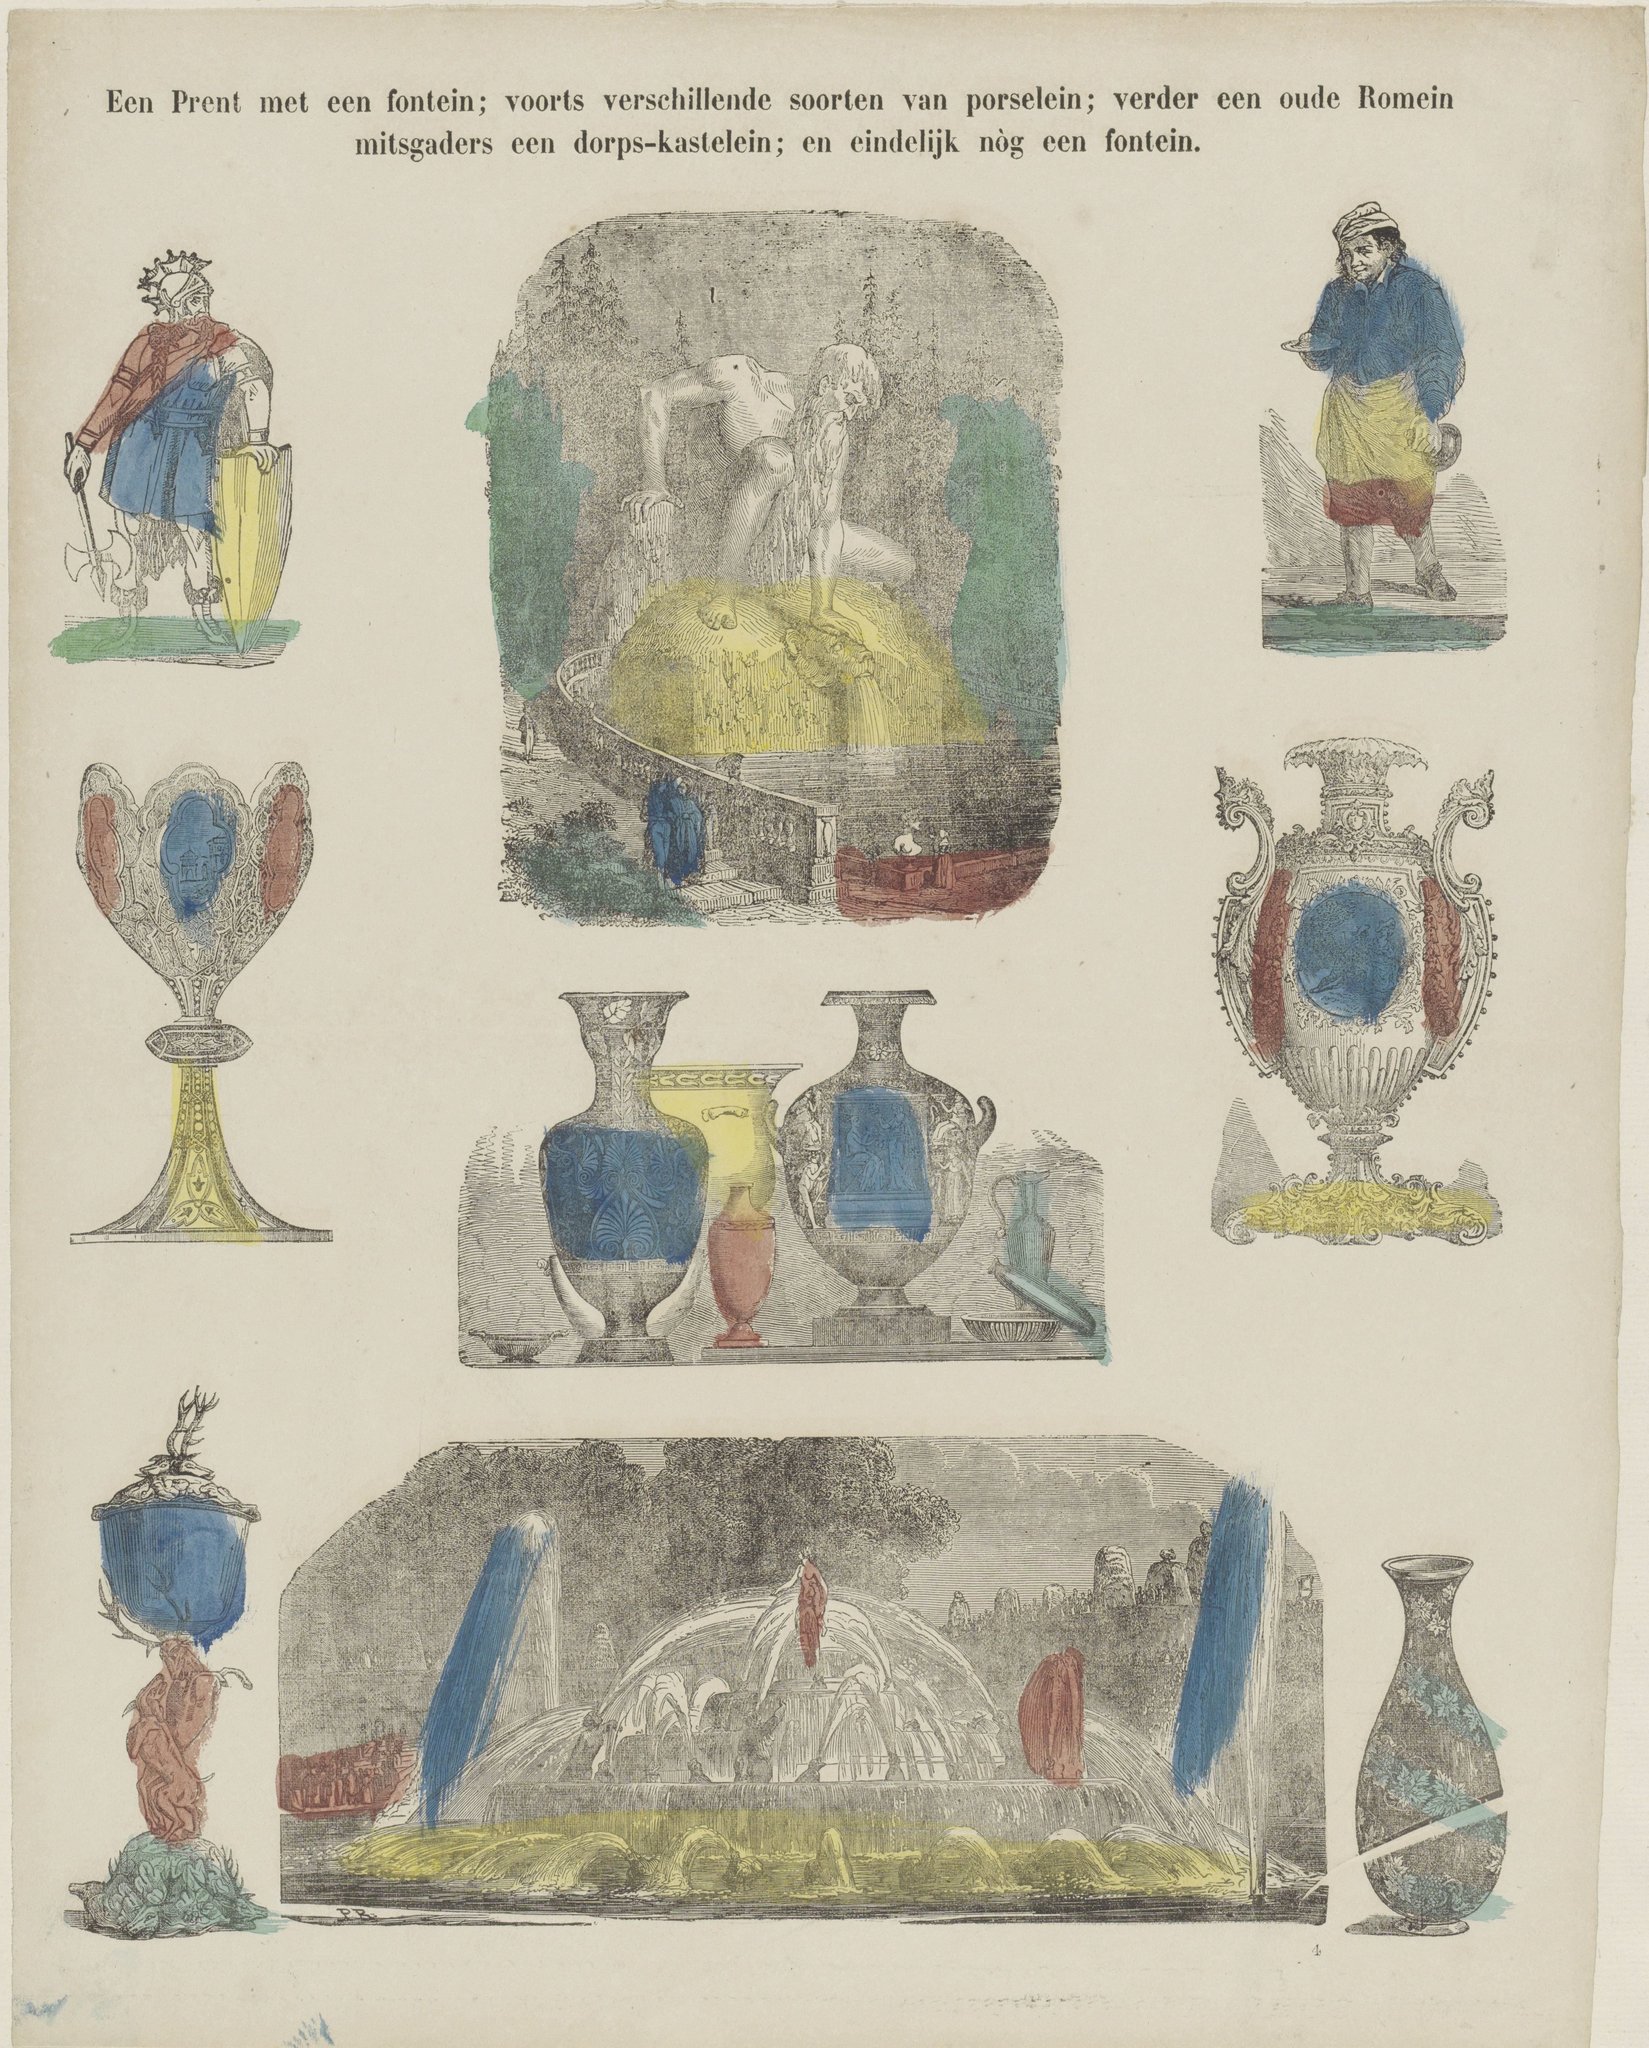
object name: print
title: Een prent met een fontein; voorts verschillende soorten van porselein; verder een oude Romein / mitsgaders een dorps-kastelein; en eindelijk nòg een fontein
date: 1861-1929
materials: paper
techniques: colour, letterpress printing, engraving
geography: france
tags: vase ~ ornament, drinking-vessels, ornamental fountain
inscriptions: collector's mark: Lugt 2760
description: Blad met 9 voorstellingen van verschillende aard, zoals voorstellingen van een Romein, van en kastelein, van vaatwerk en van fonteinen. Genummerd rechtsonder: 4.